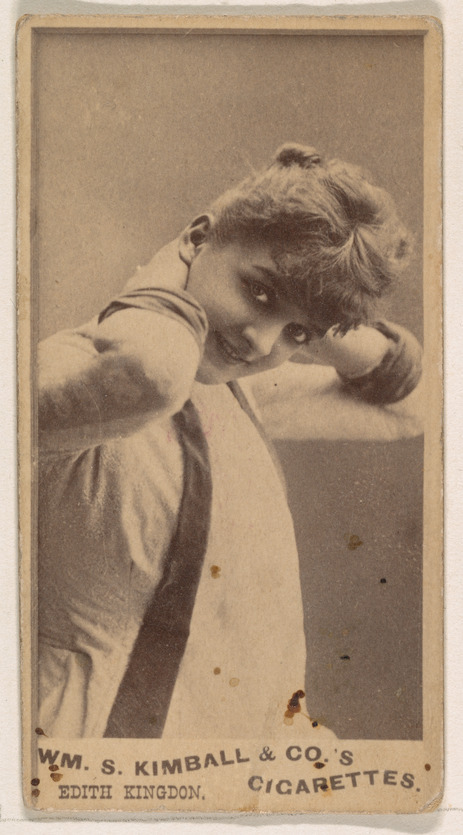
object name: photograph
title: Edith Kingdon, from the Actresses series (N203) issued by Wm. S. Kimball & Co.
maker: william s. kimball & company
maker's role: publisher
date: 1889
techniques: color lithograph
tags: portraits,women,actresses